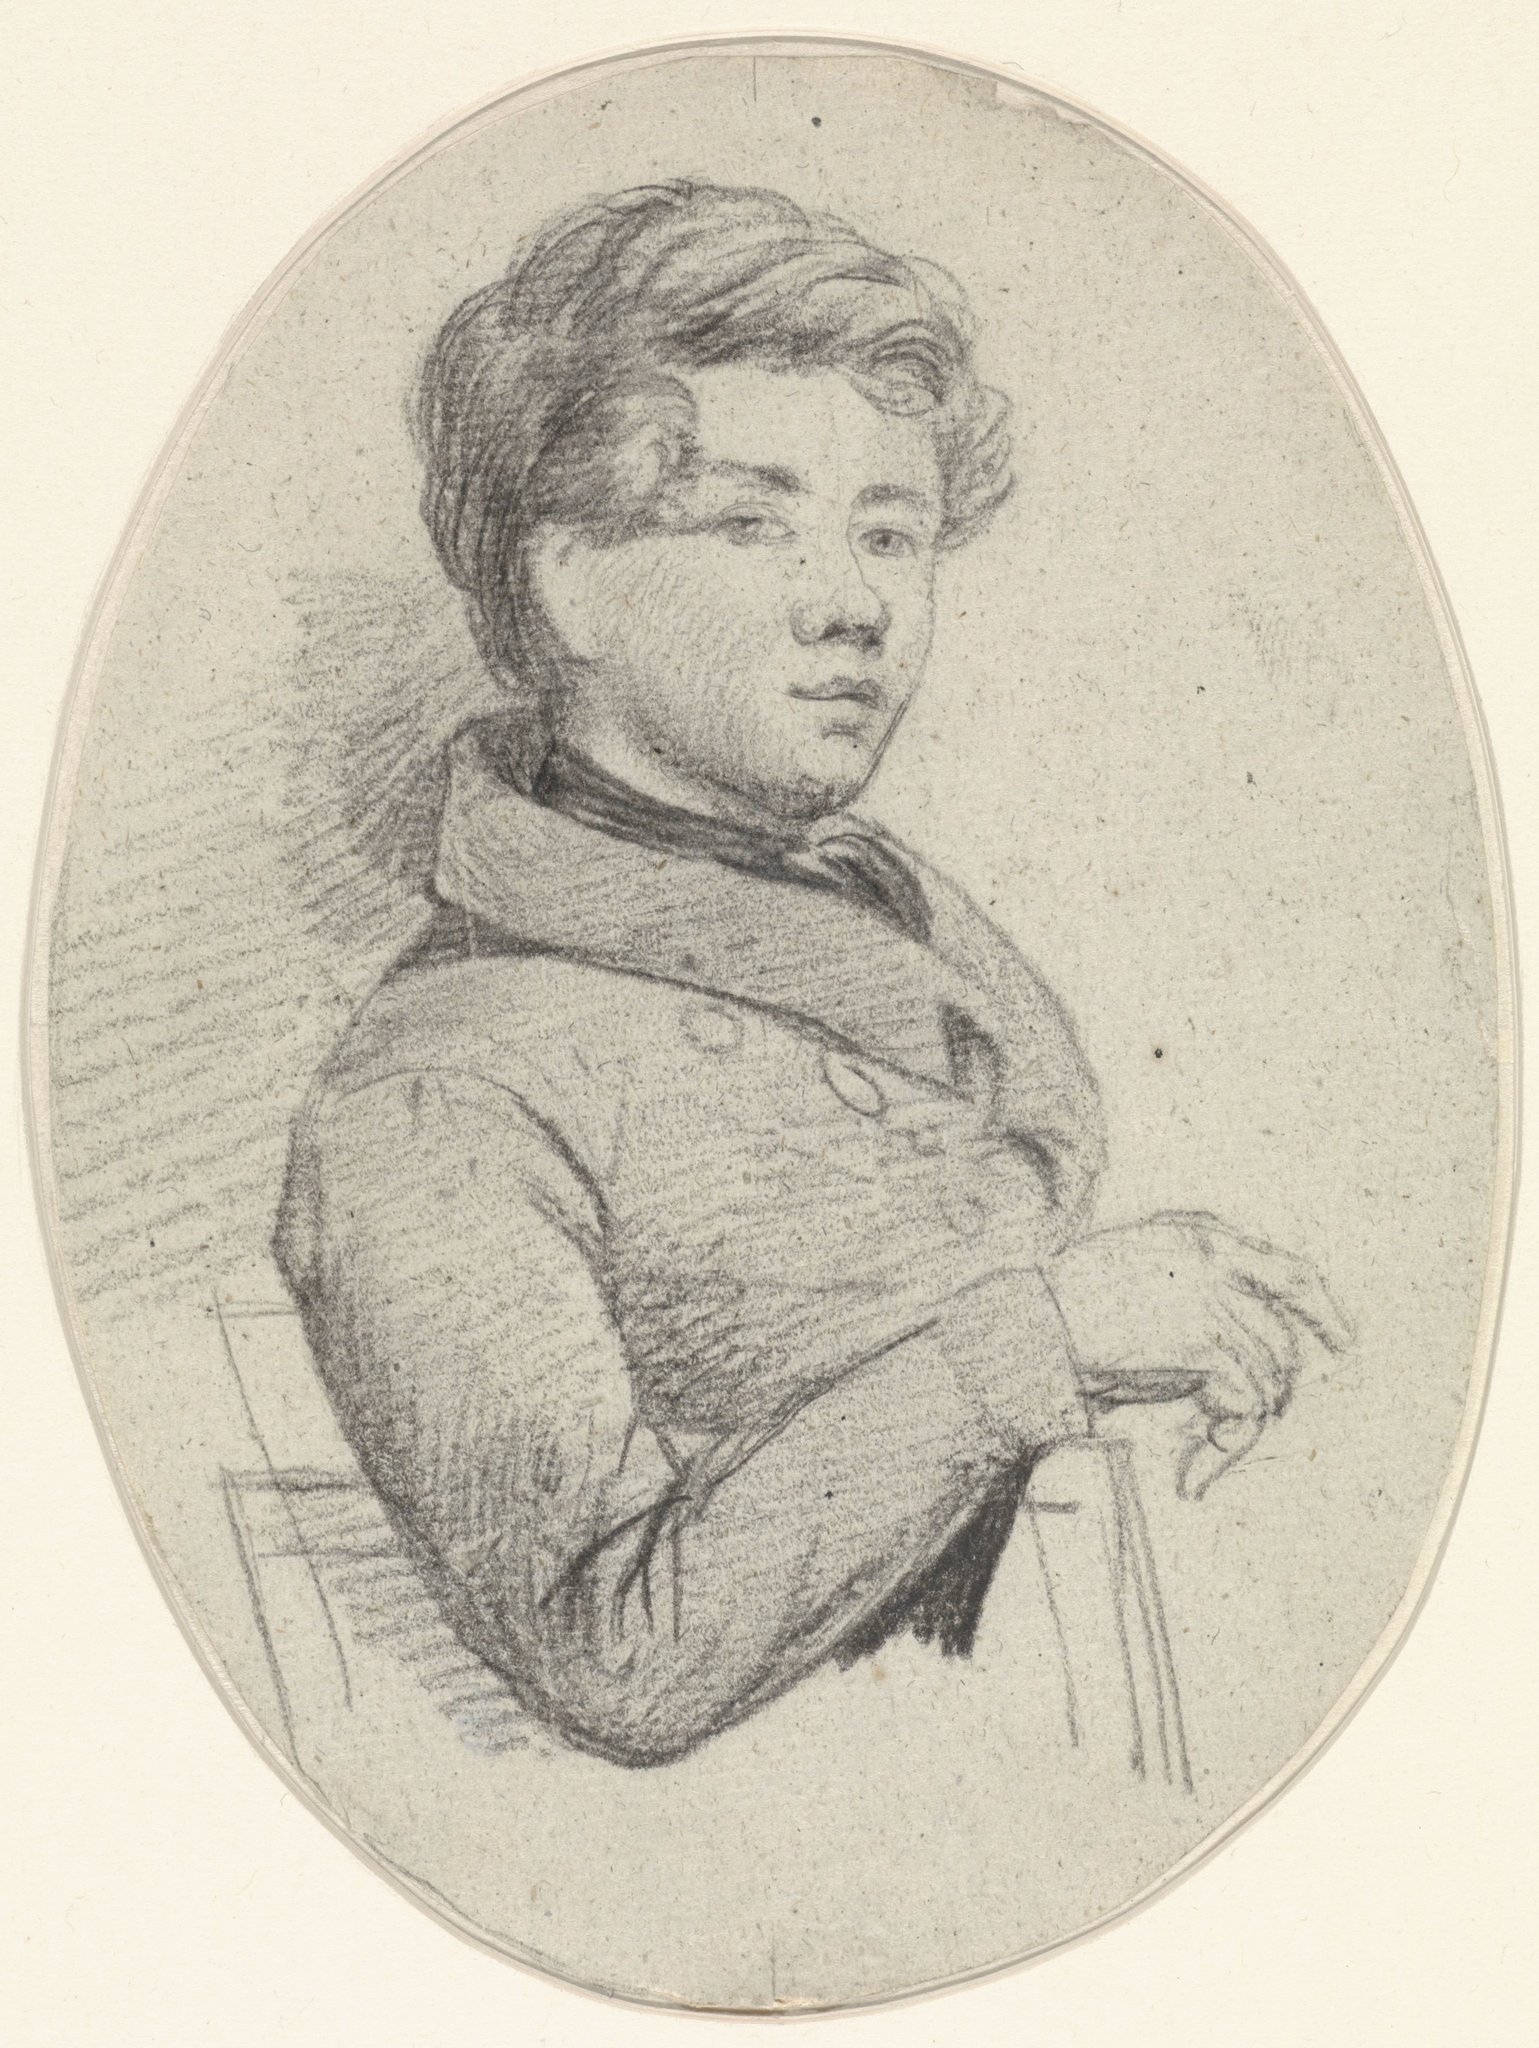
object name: drawing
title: Portret van George Gillis Haanen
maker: gijsbertus craeyvanger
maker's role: draughtsman, print maker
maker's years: 1810-1895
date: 1817-1819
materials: chalk, paper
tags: utrecht, draughtsman, george gillis haanen, historical persons, portrait, self-portrait of painter, portrait, self-portrait of artist, portrait, self-portrait of draughtsman